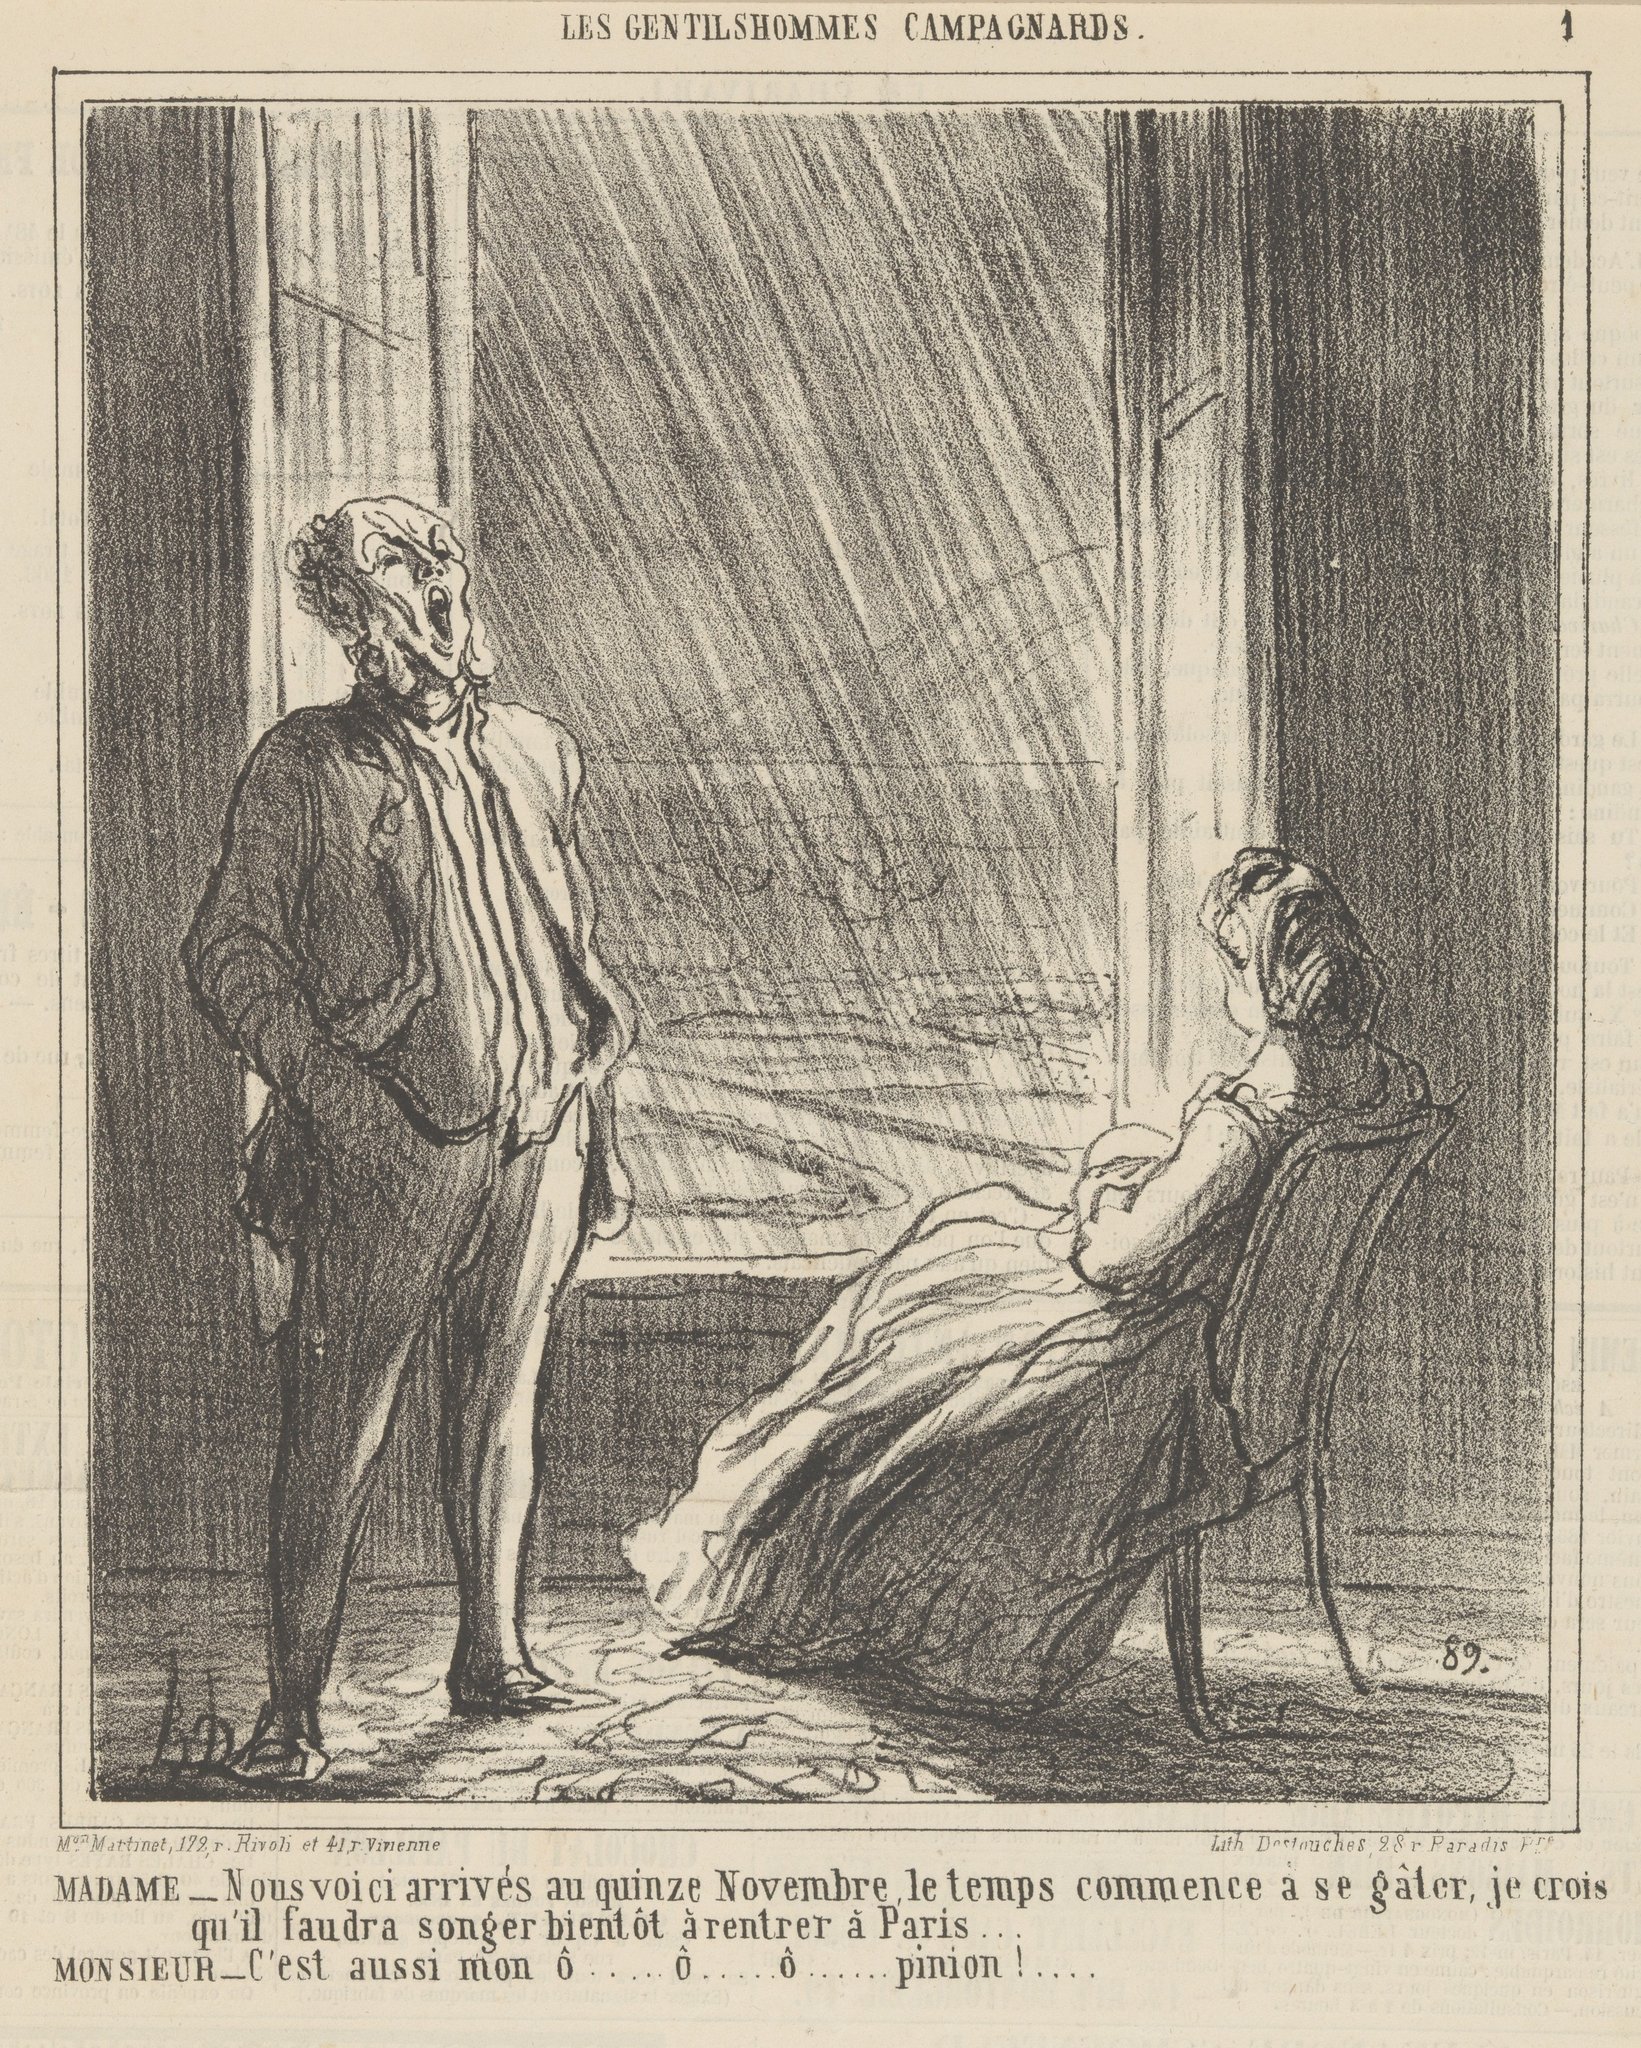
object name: print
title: We are approaching mid-November when the weather starts getting nasty, from 'The countryside gentlemen,' published in Le Charivari, November 28, 1864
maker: honoré daumier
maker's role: artist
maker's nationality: french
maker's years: 1808-1879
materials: paper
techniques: lithograph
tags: men,women